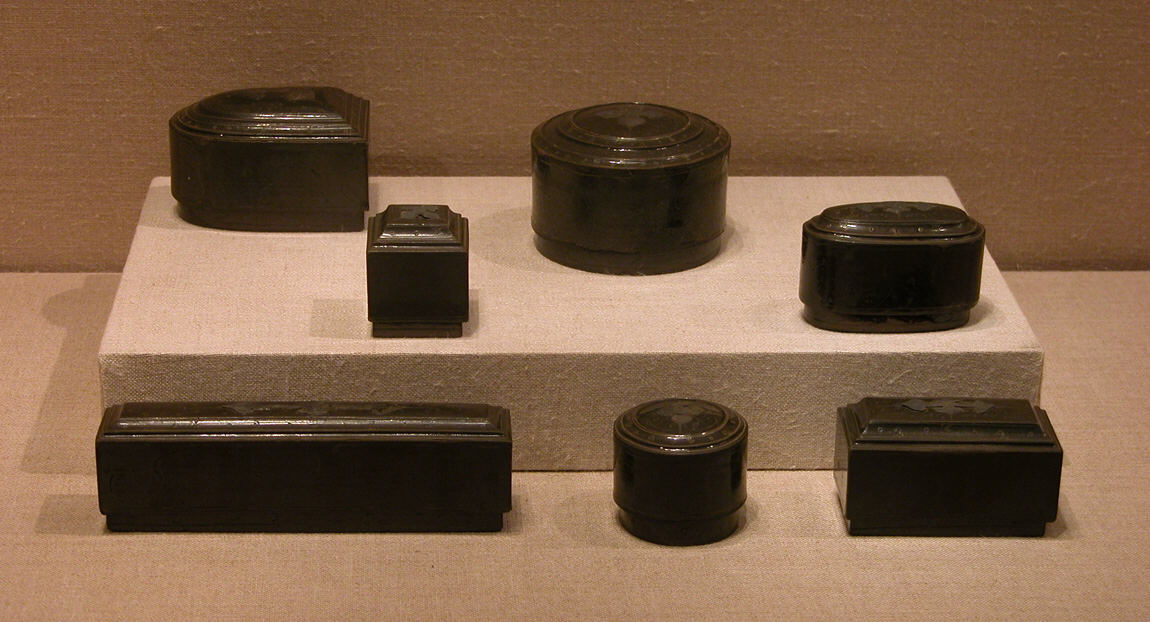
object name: set of box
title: Set of Seven Boxes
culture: chinese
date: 101-300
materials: foil, lacquer, silver